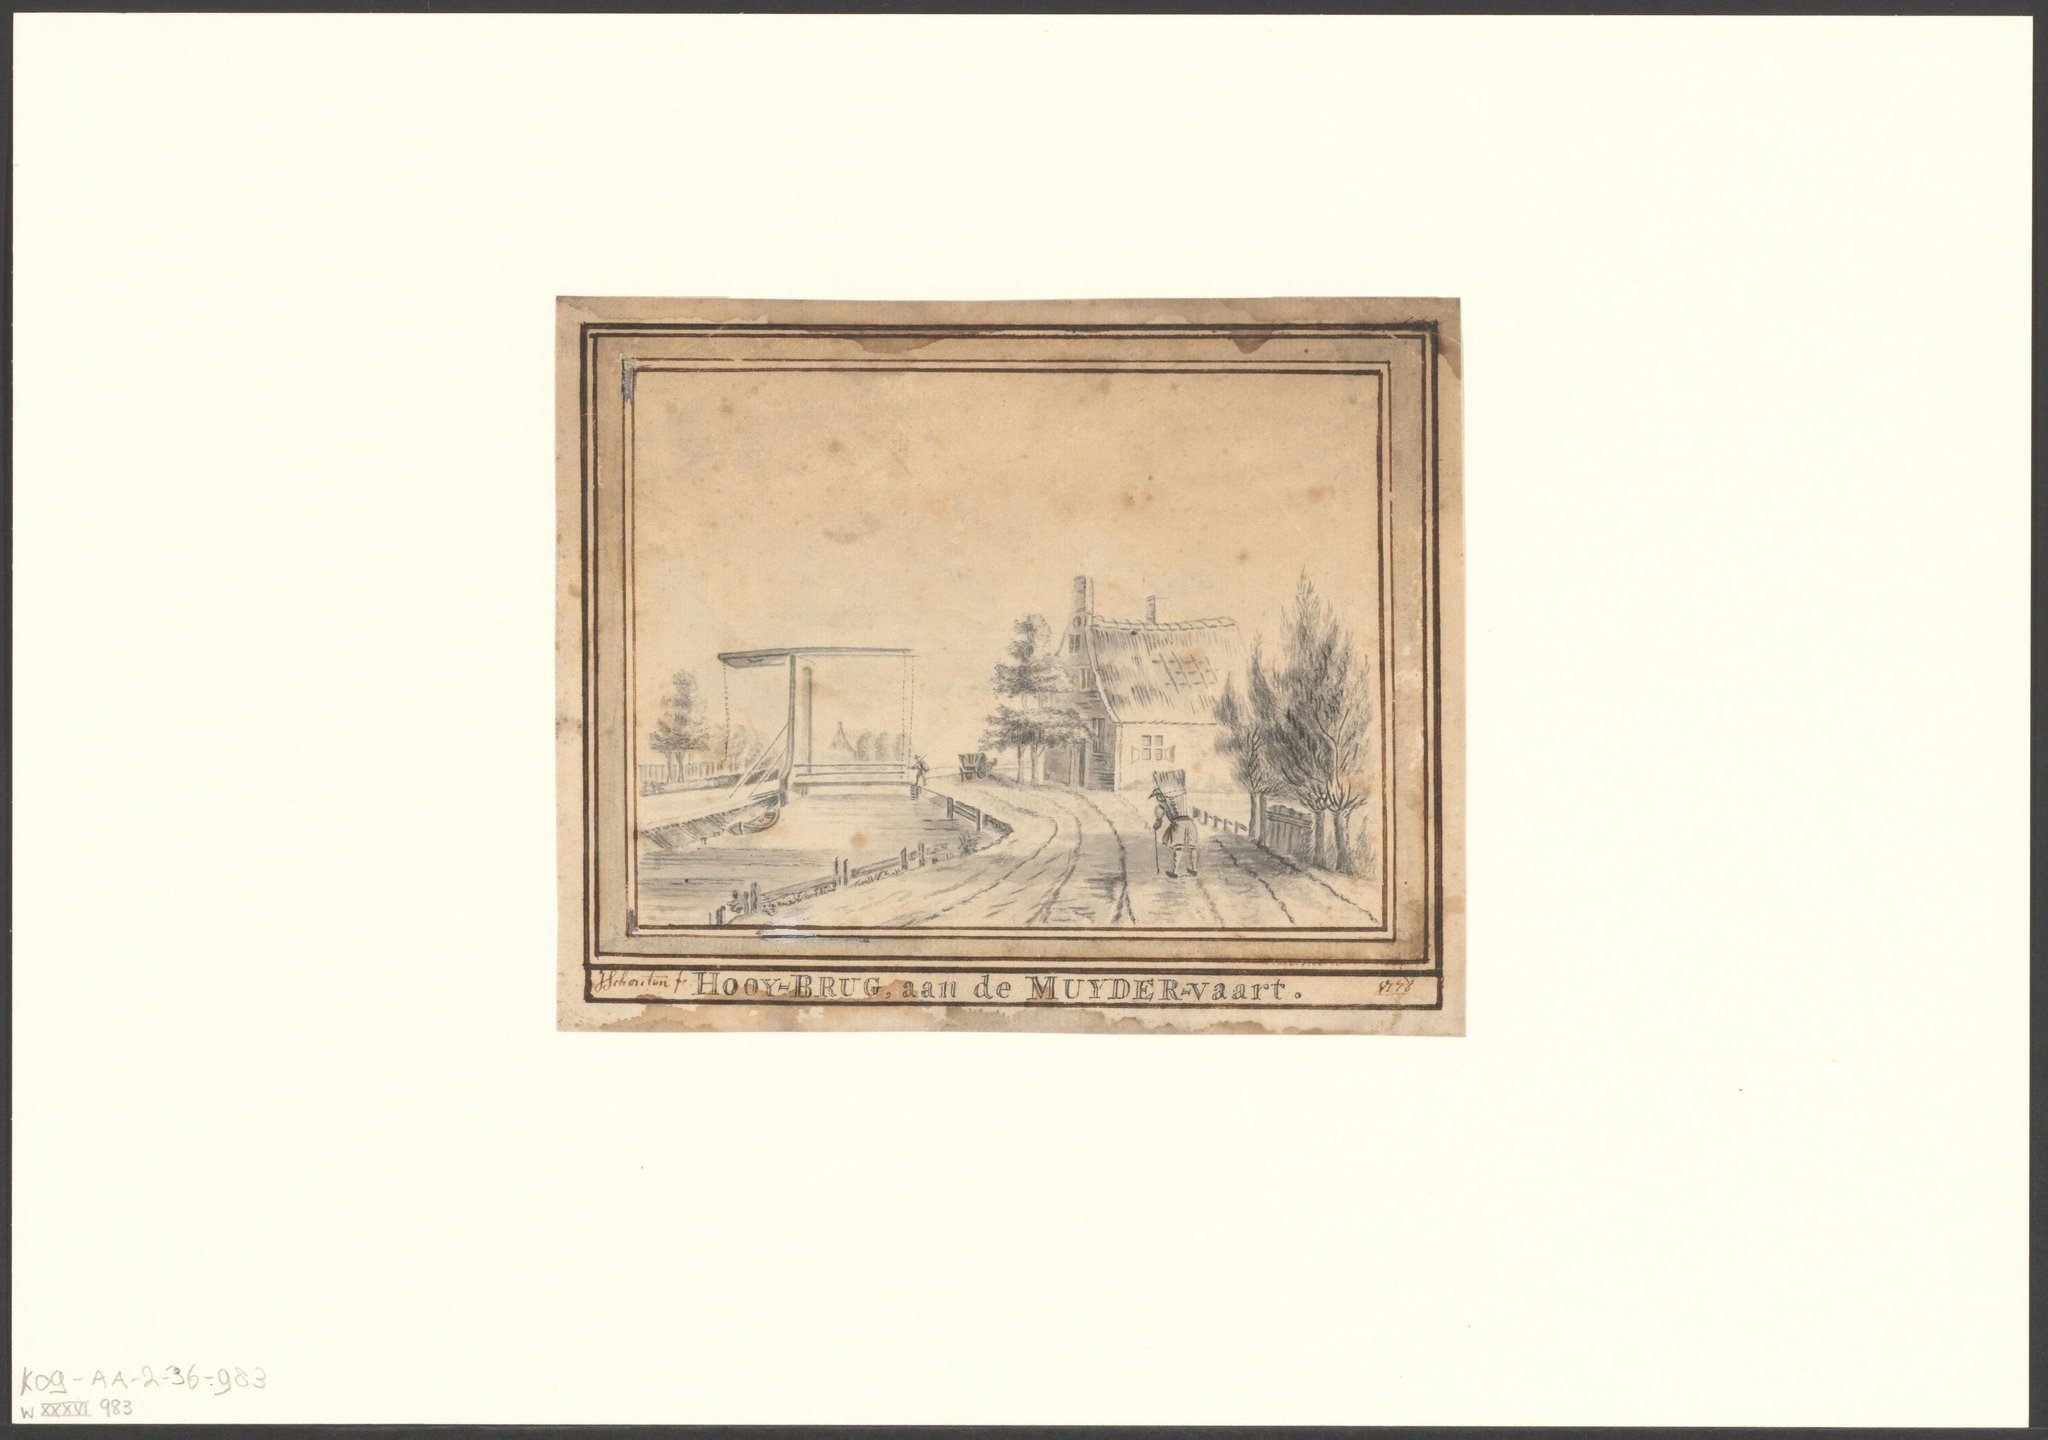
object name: drawing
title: Gezicht op de Hooibrug bij Muiden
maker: hermanus petrus schouten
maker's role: draughtsman, painter, print maker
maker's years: 1747-1822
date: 1778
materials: ink, paper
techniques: brush, pen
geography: muiden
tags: canal, village, road, path, bridge in village across river, canal, etc.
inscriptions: inscription: ‘Hooy-brug aan de Muyder-vaart’, signature and date: ‘HSchouten f. / 1778’, collector's mark: Lugt 800a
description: Tekening binnen de Atlas Van Eck ingedeeld op wijknummer 36.